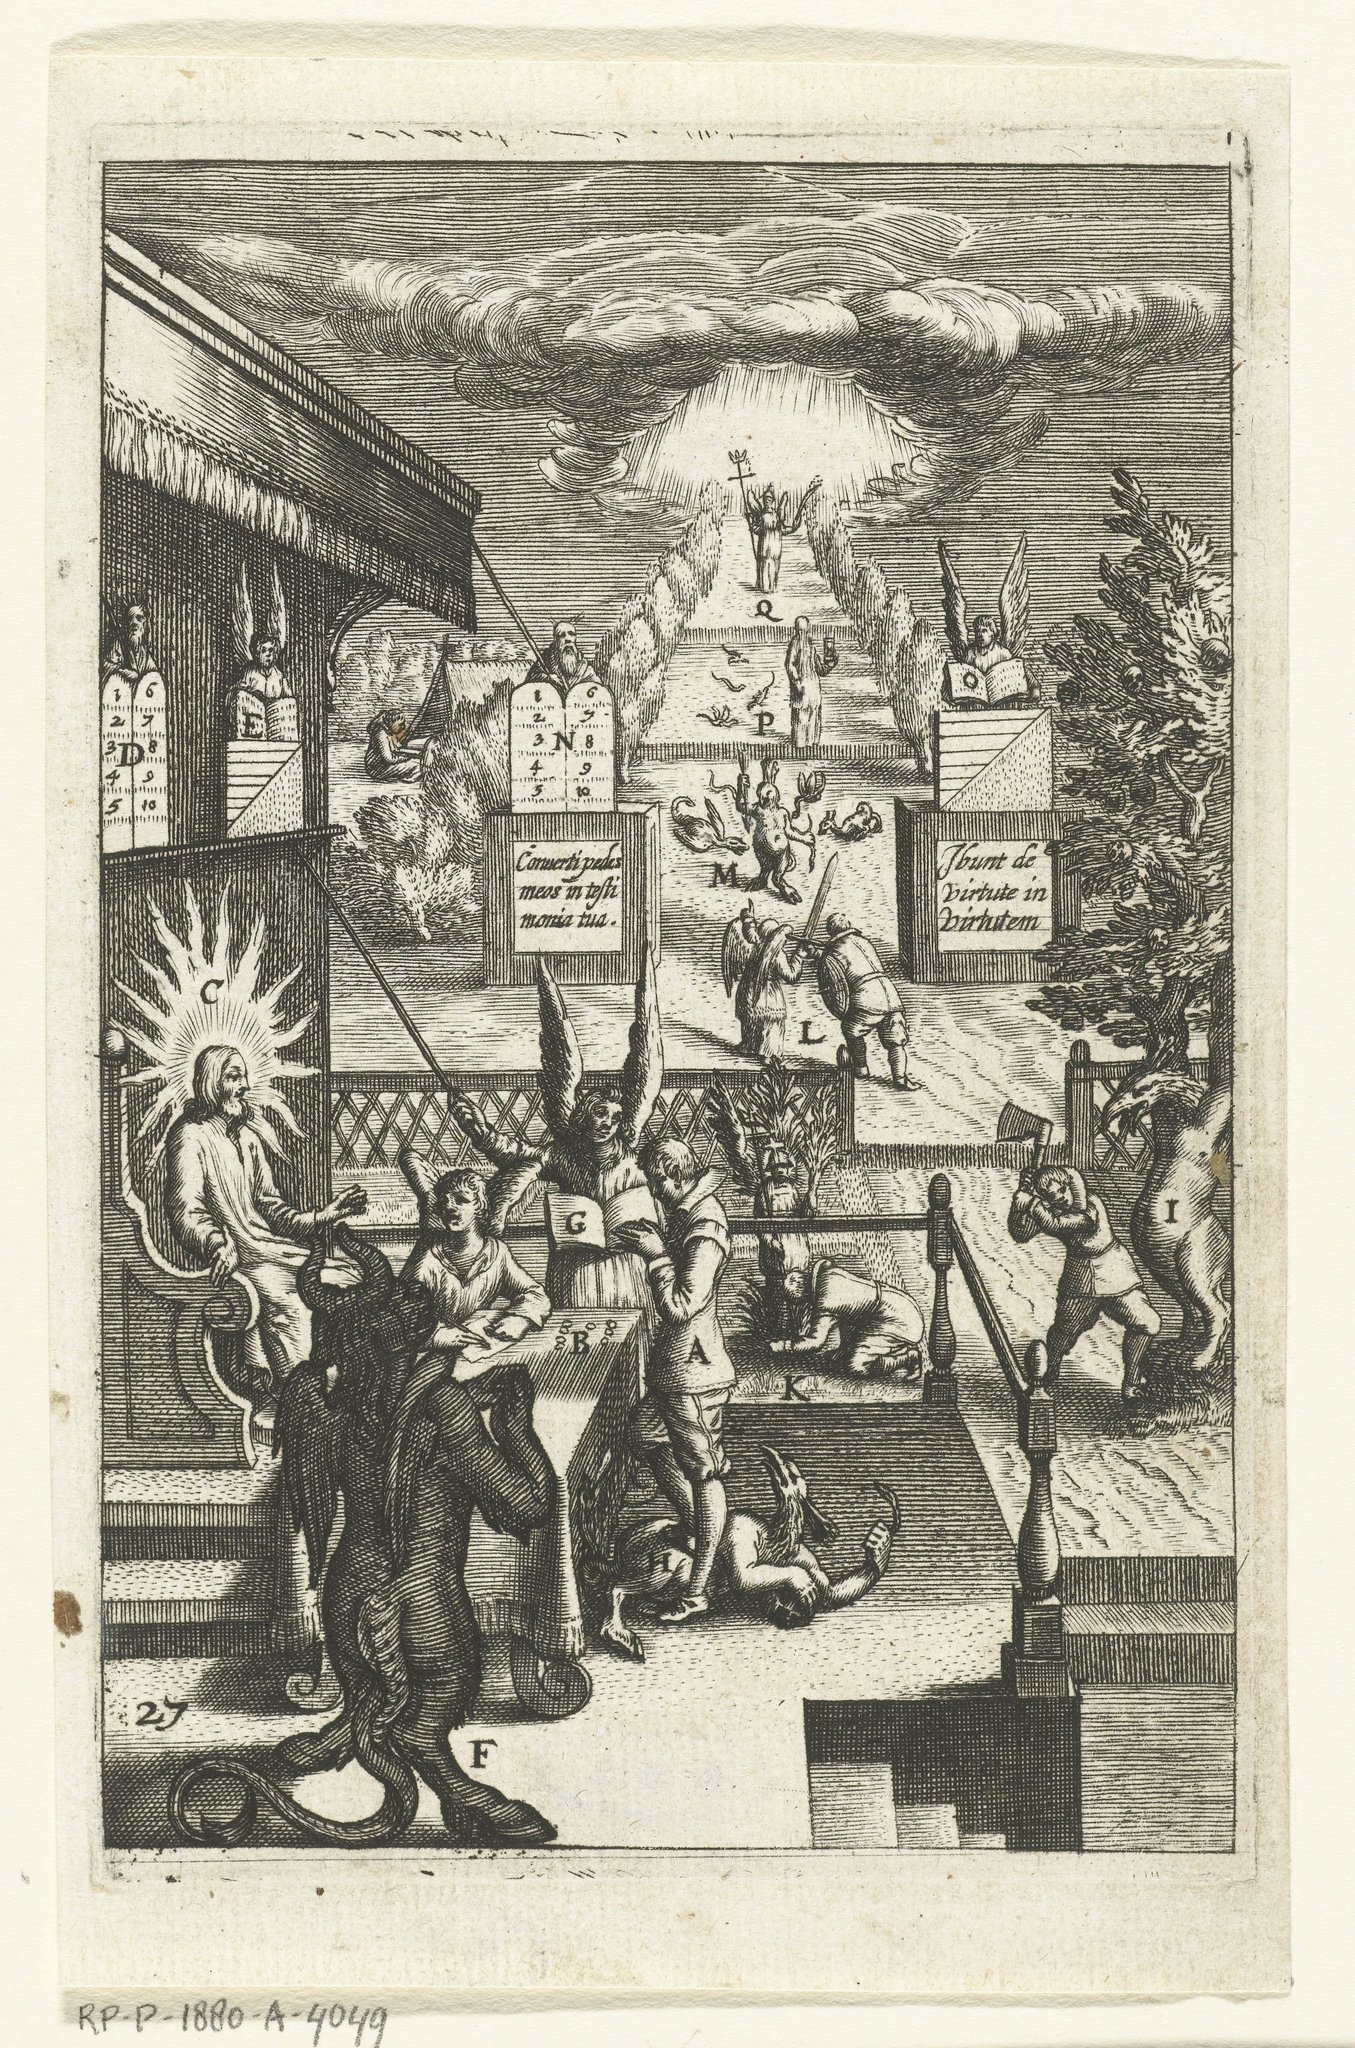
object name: print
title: Embleem met man die door Christus als rechter beoordeeld wordt op zijn gebreken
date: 1620-1623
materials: paper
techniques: engraving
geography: antwerp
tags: devil(s) and demons, christ as (heavenly) judge, the life of man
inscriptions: collector's mark: Lugt 2228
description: Een man vraagt Christus als rechter de rekening van zijn zonden. De duivel doet een slecht woordje voor hem. Volgens het meditatievoorschrift moet hij bij zichzelf nagaan welke gebreken hij heeft en proberen de zonde uit zijn leven te bannen door volgens de tien geboden te leven.